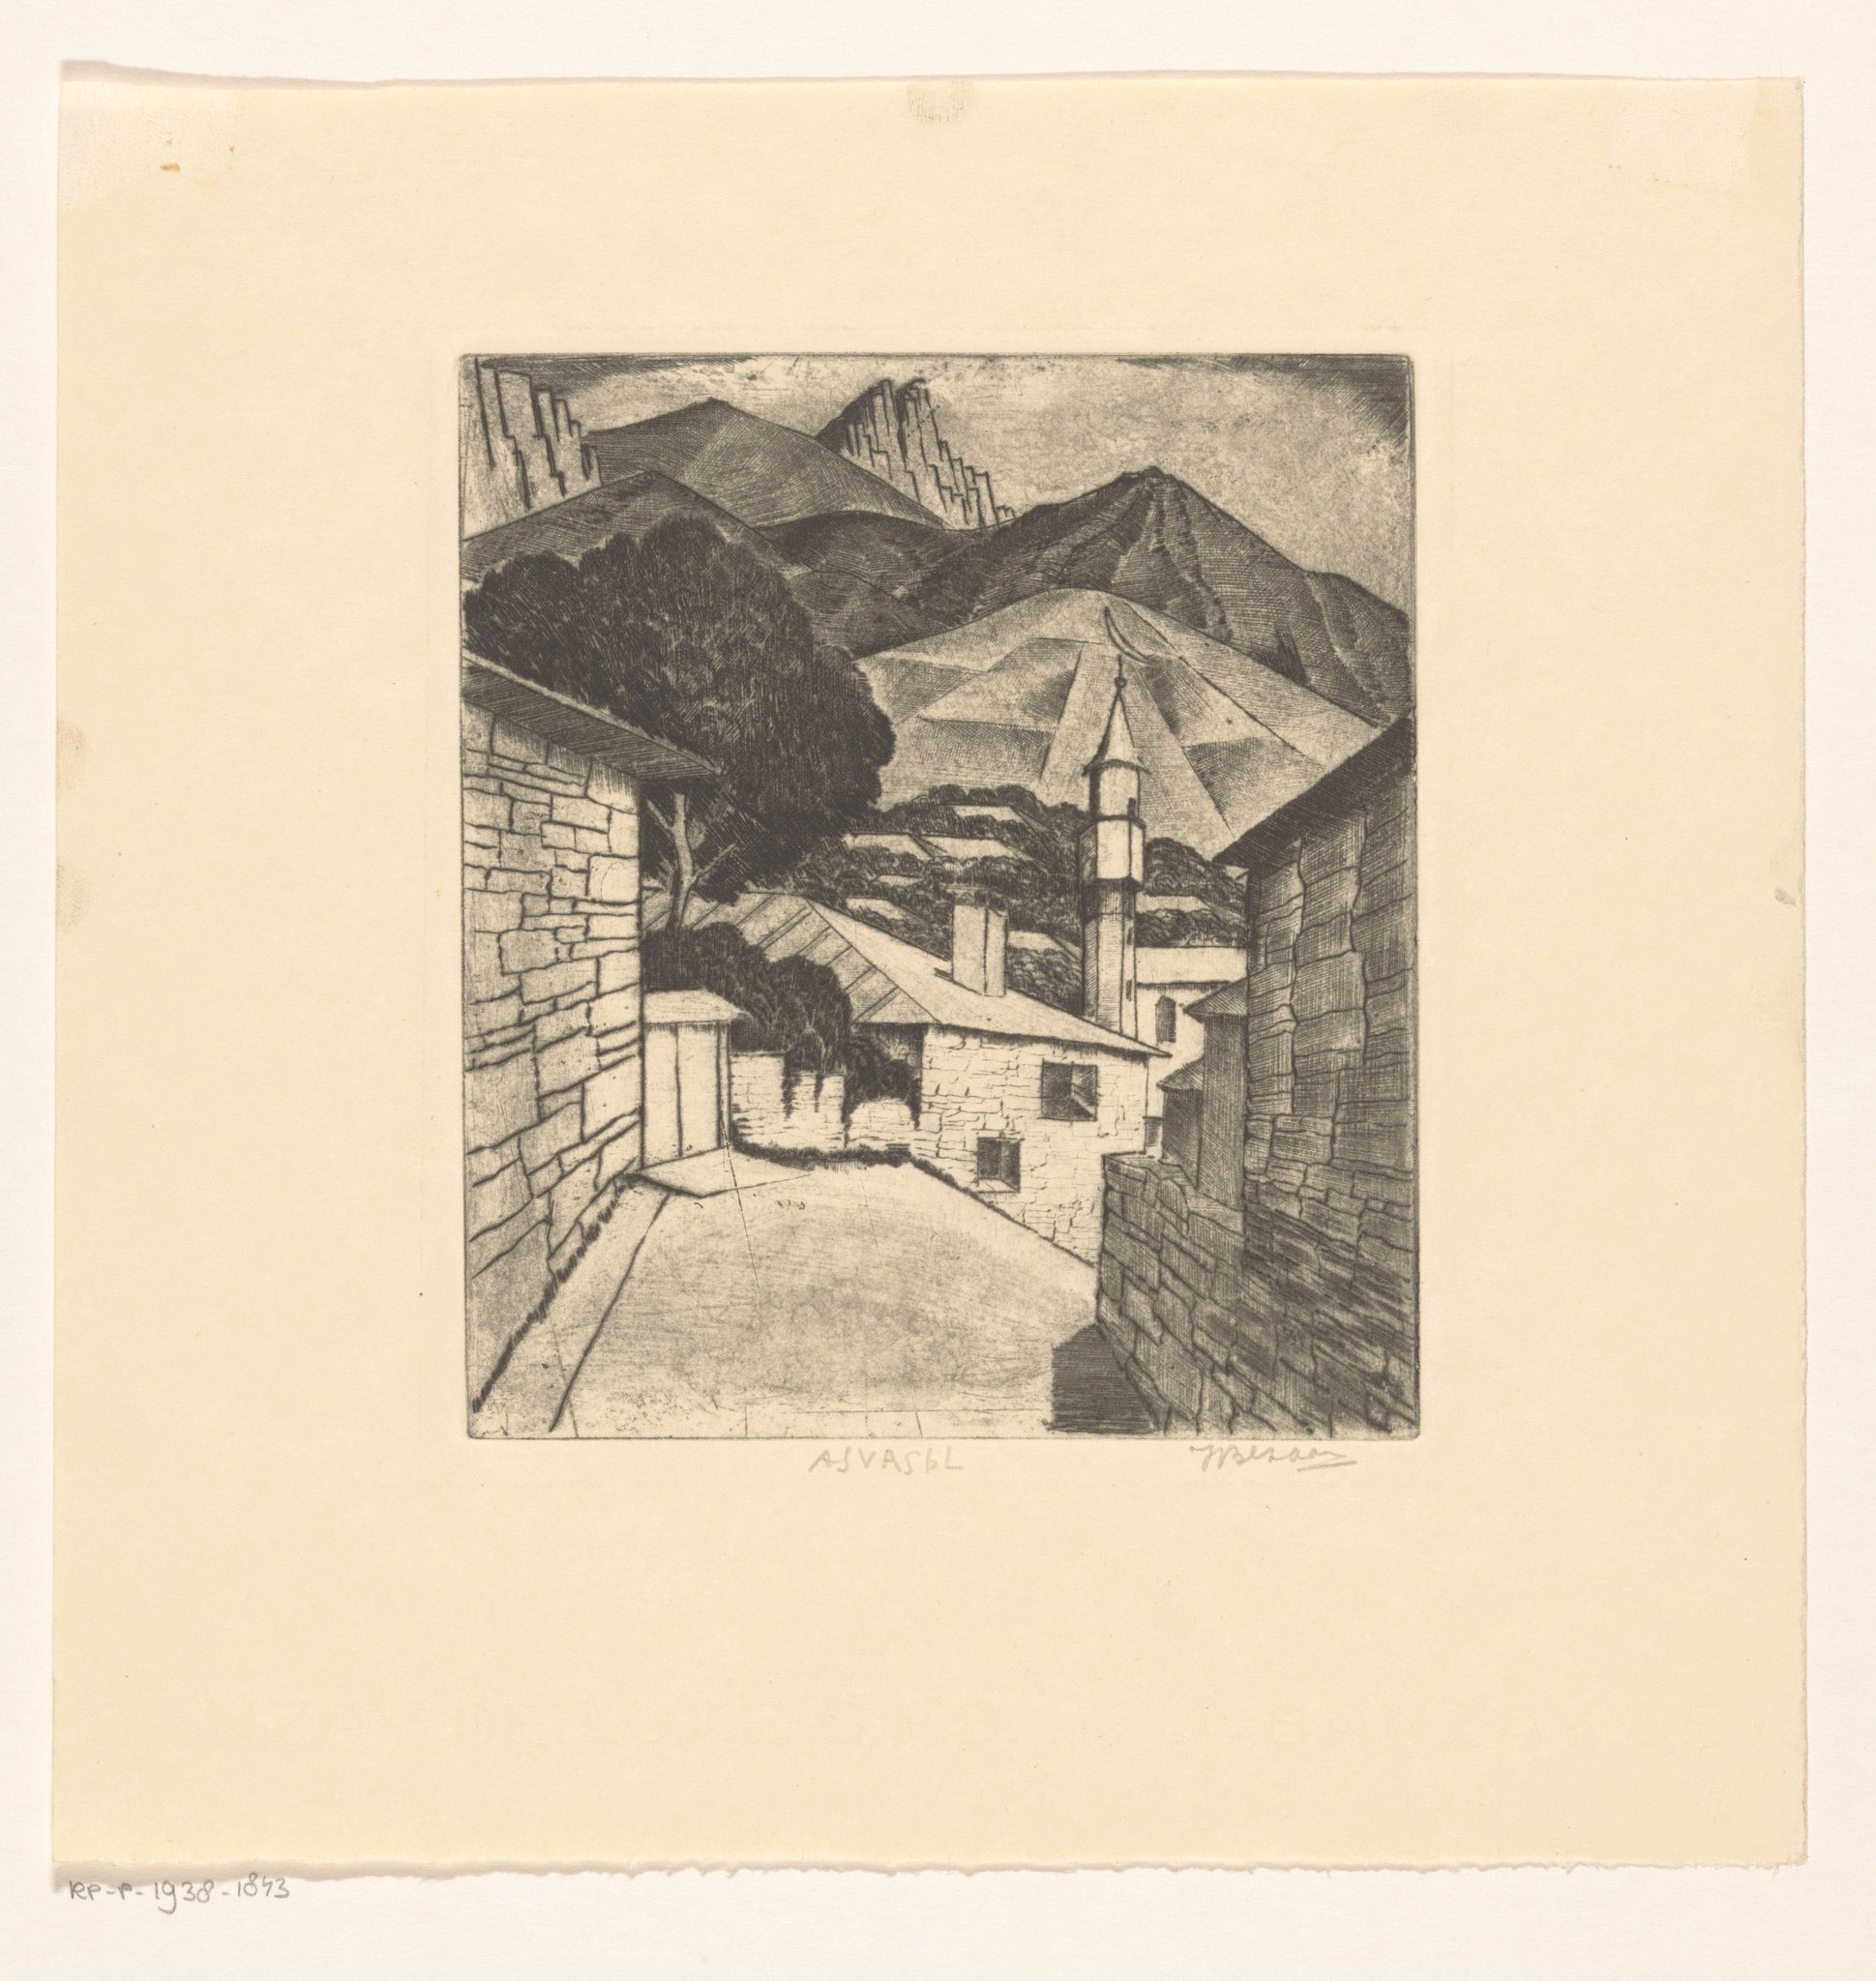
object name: print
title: Asvasbl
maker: jo bezaan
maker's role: draughtsman, print maker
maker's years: 1894-1952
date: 1904-1938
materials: paper, ink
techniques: drypoint, etching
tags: village lane, alley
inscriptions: collector's mark: Lugt 2228, signature: ‘Jbezaan’, title: ‘Asvasbl’